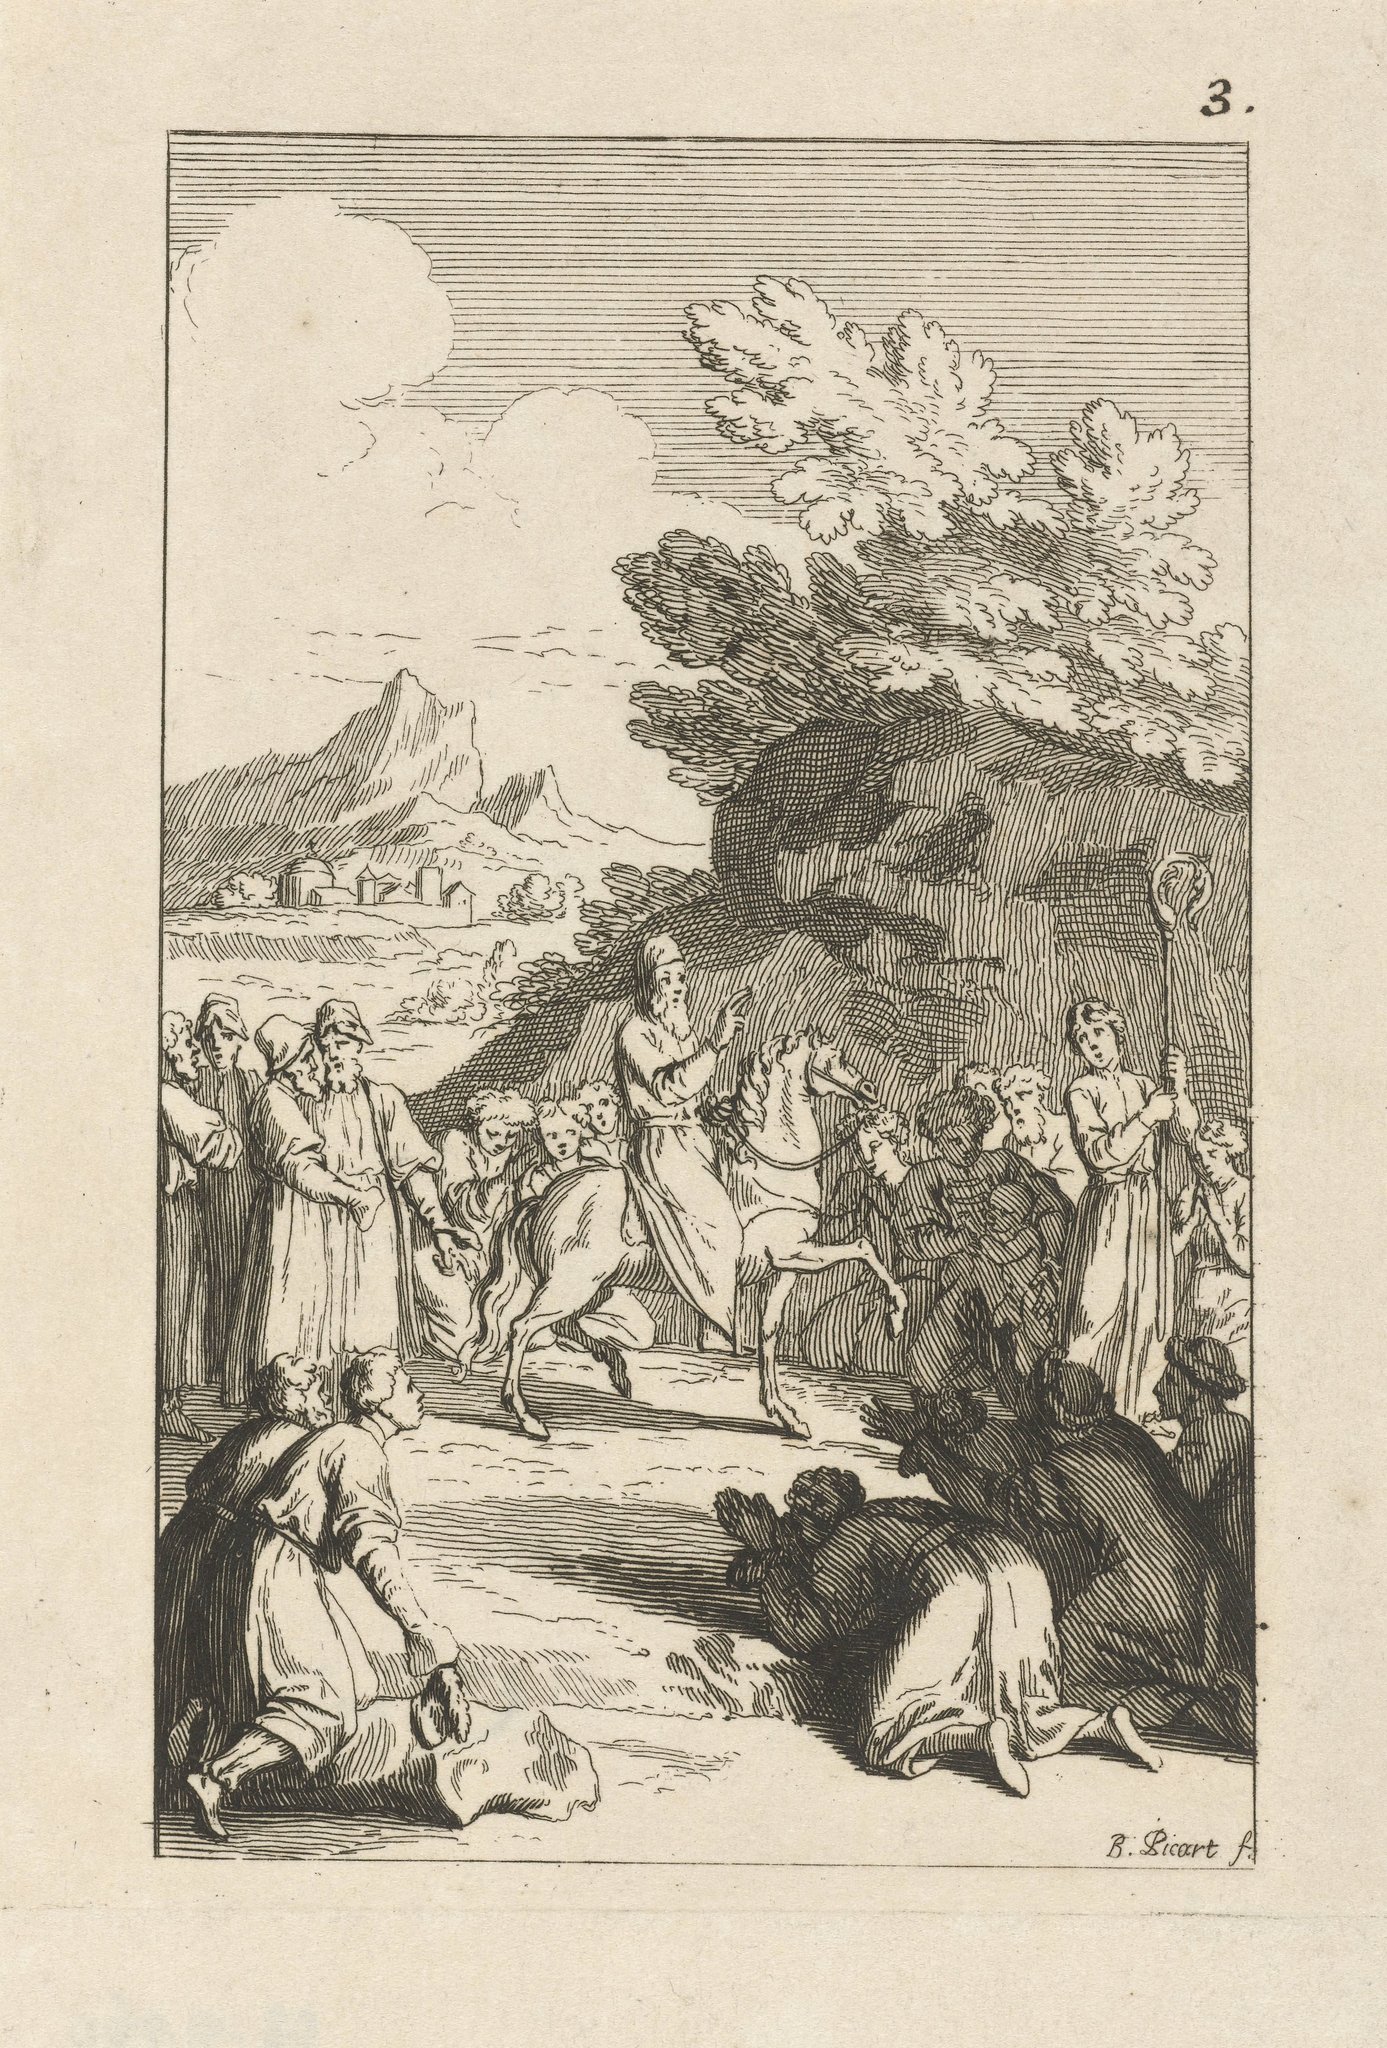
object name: print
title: Een evangeliserende geestelijke te paard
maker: bernard picart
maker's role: draughtsman, print maker, publisher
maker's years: 1673-1733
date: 1683-1733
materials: paper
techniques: engraving, etching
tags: preaching (in general)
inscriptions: collector's mark: Lugt 2228, number: ‘3.’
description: Landschap met een geestelijke te paard, omringd door toehoorders. Hij predikt het evangelie en de mensen knielen voor hem in aanbidding.